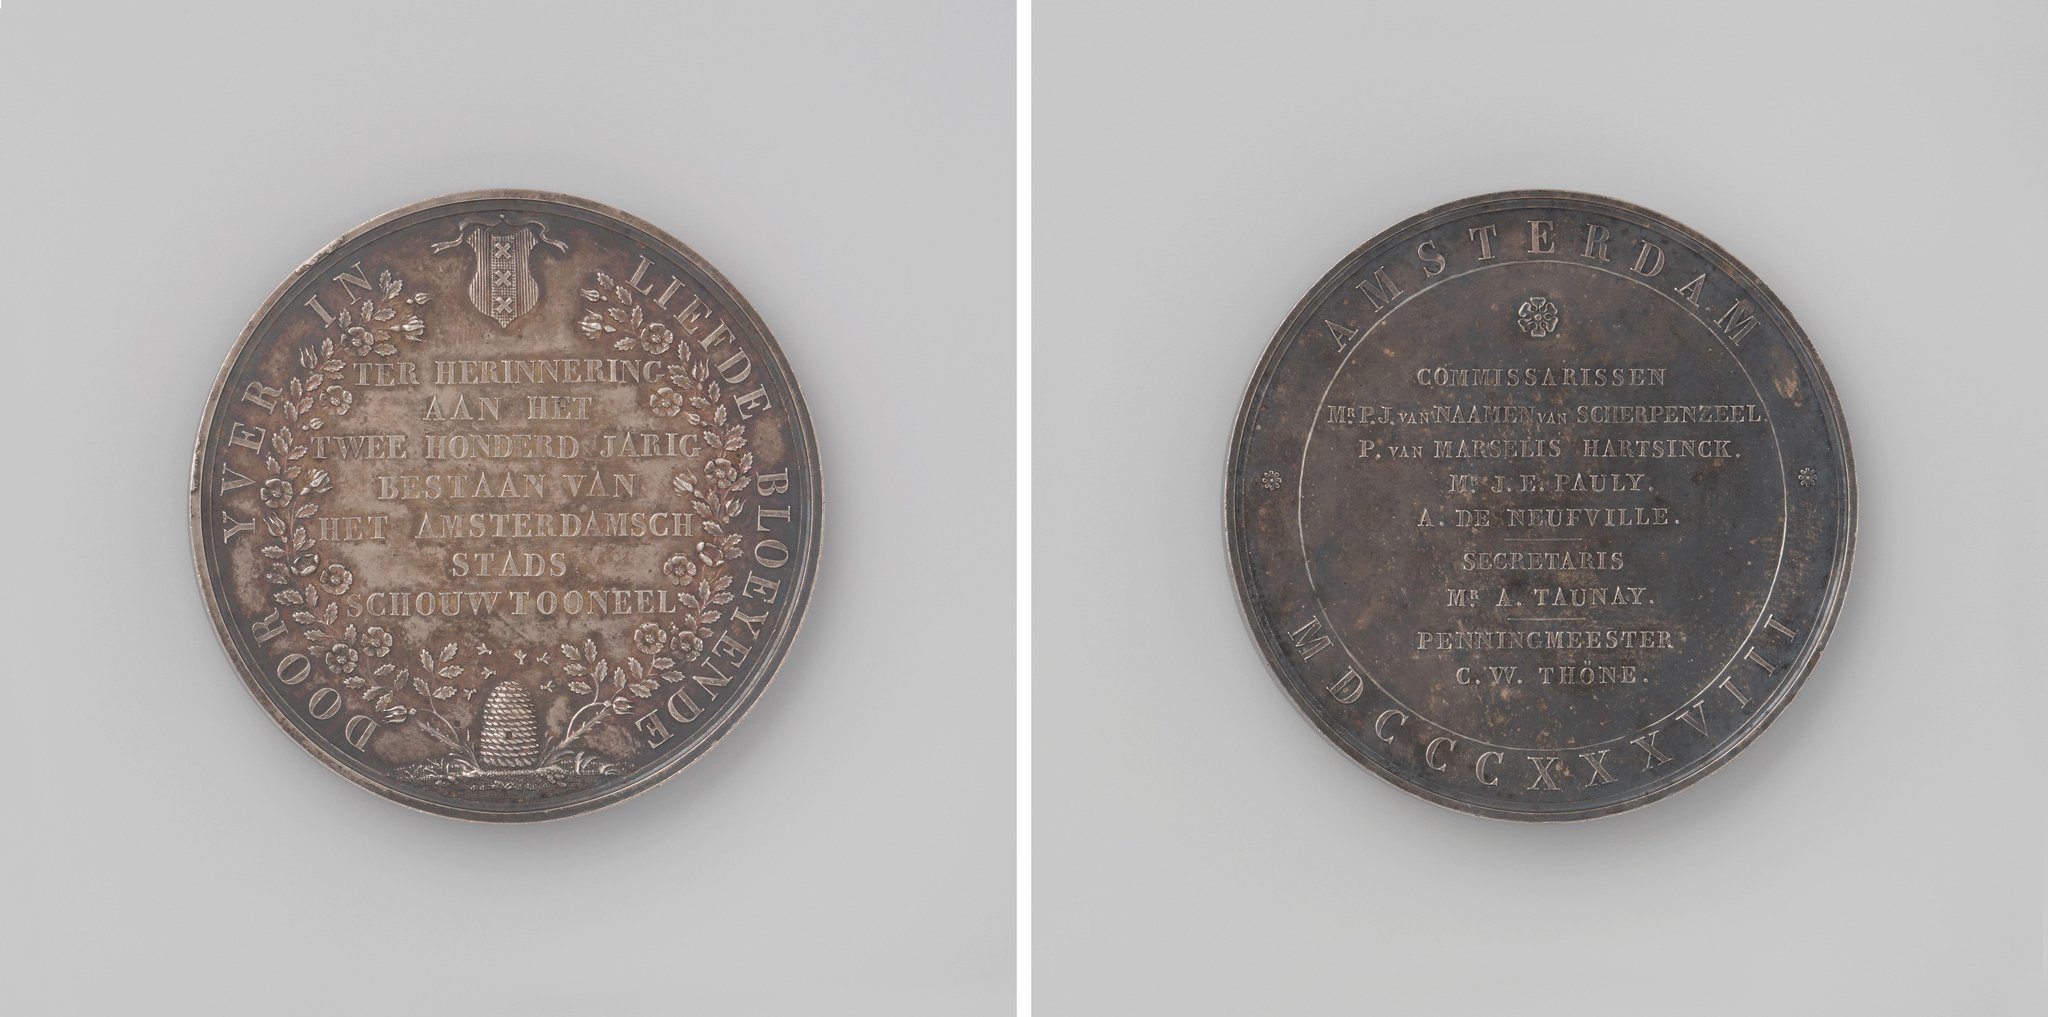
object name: history medal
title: Tweehonderdjarig bestaan van het Amsterdams stadsschouwtoneel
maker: david van der kellen (1804-1879)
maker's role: die cutter, draughtsman, print maker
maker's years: 1804-1879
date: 1838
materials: silver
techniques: striking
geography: utrecht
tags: amsterdam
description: Zilveren penning. Voorzijde: opschrift boven bijenkorf, waaruit twee egelantiertakken spruiten, onderwapenschild aan lint binnen omschrift. Keerzijde: opschrift binnen omschrift